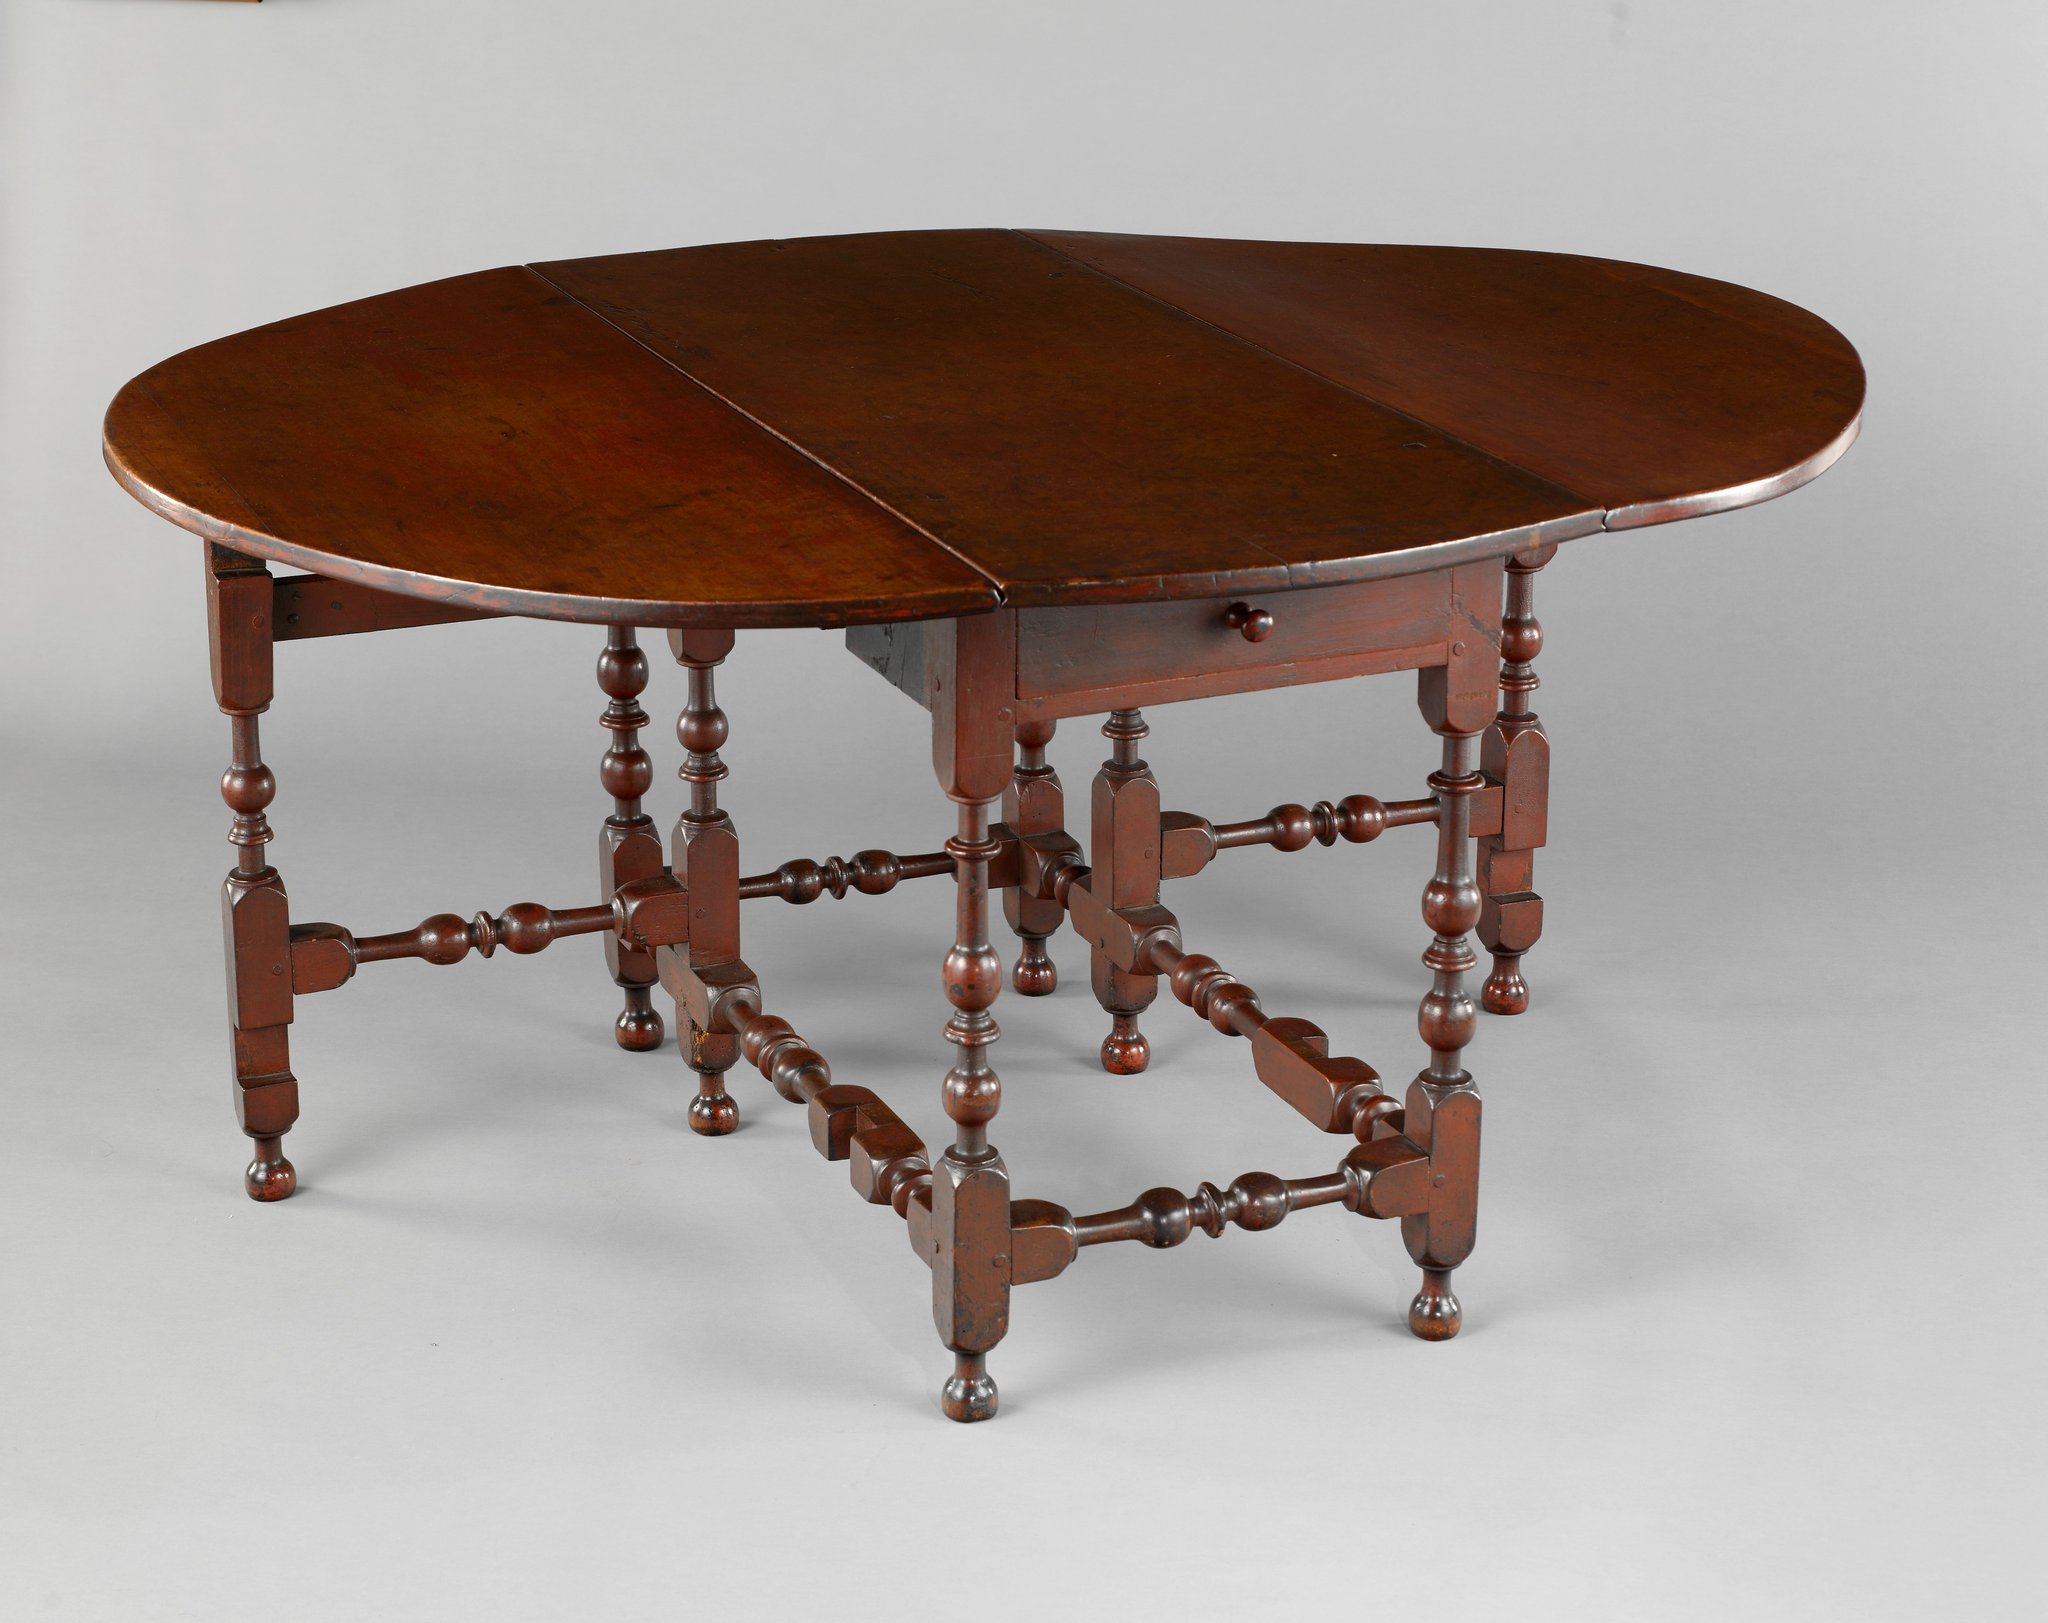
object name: table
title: Oval table with falling leaves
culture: american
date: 1715-1740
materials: wood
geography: united states